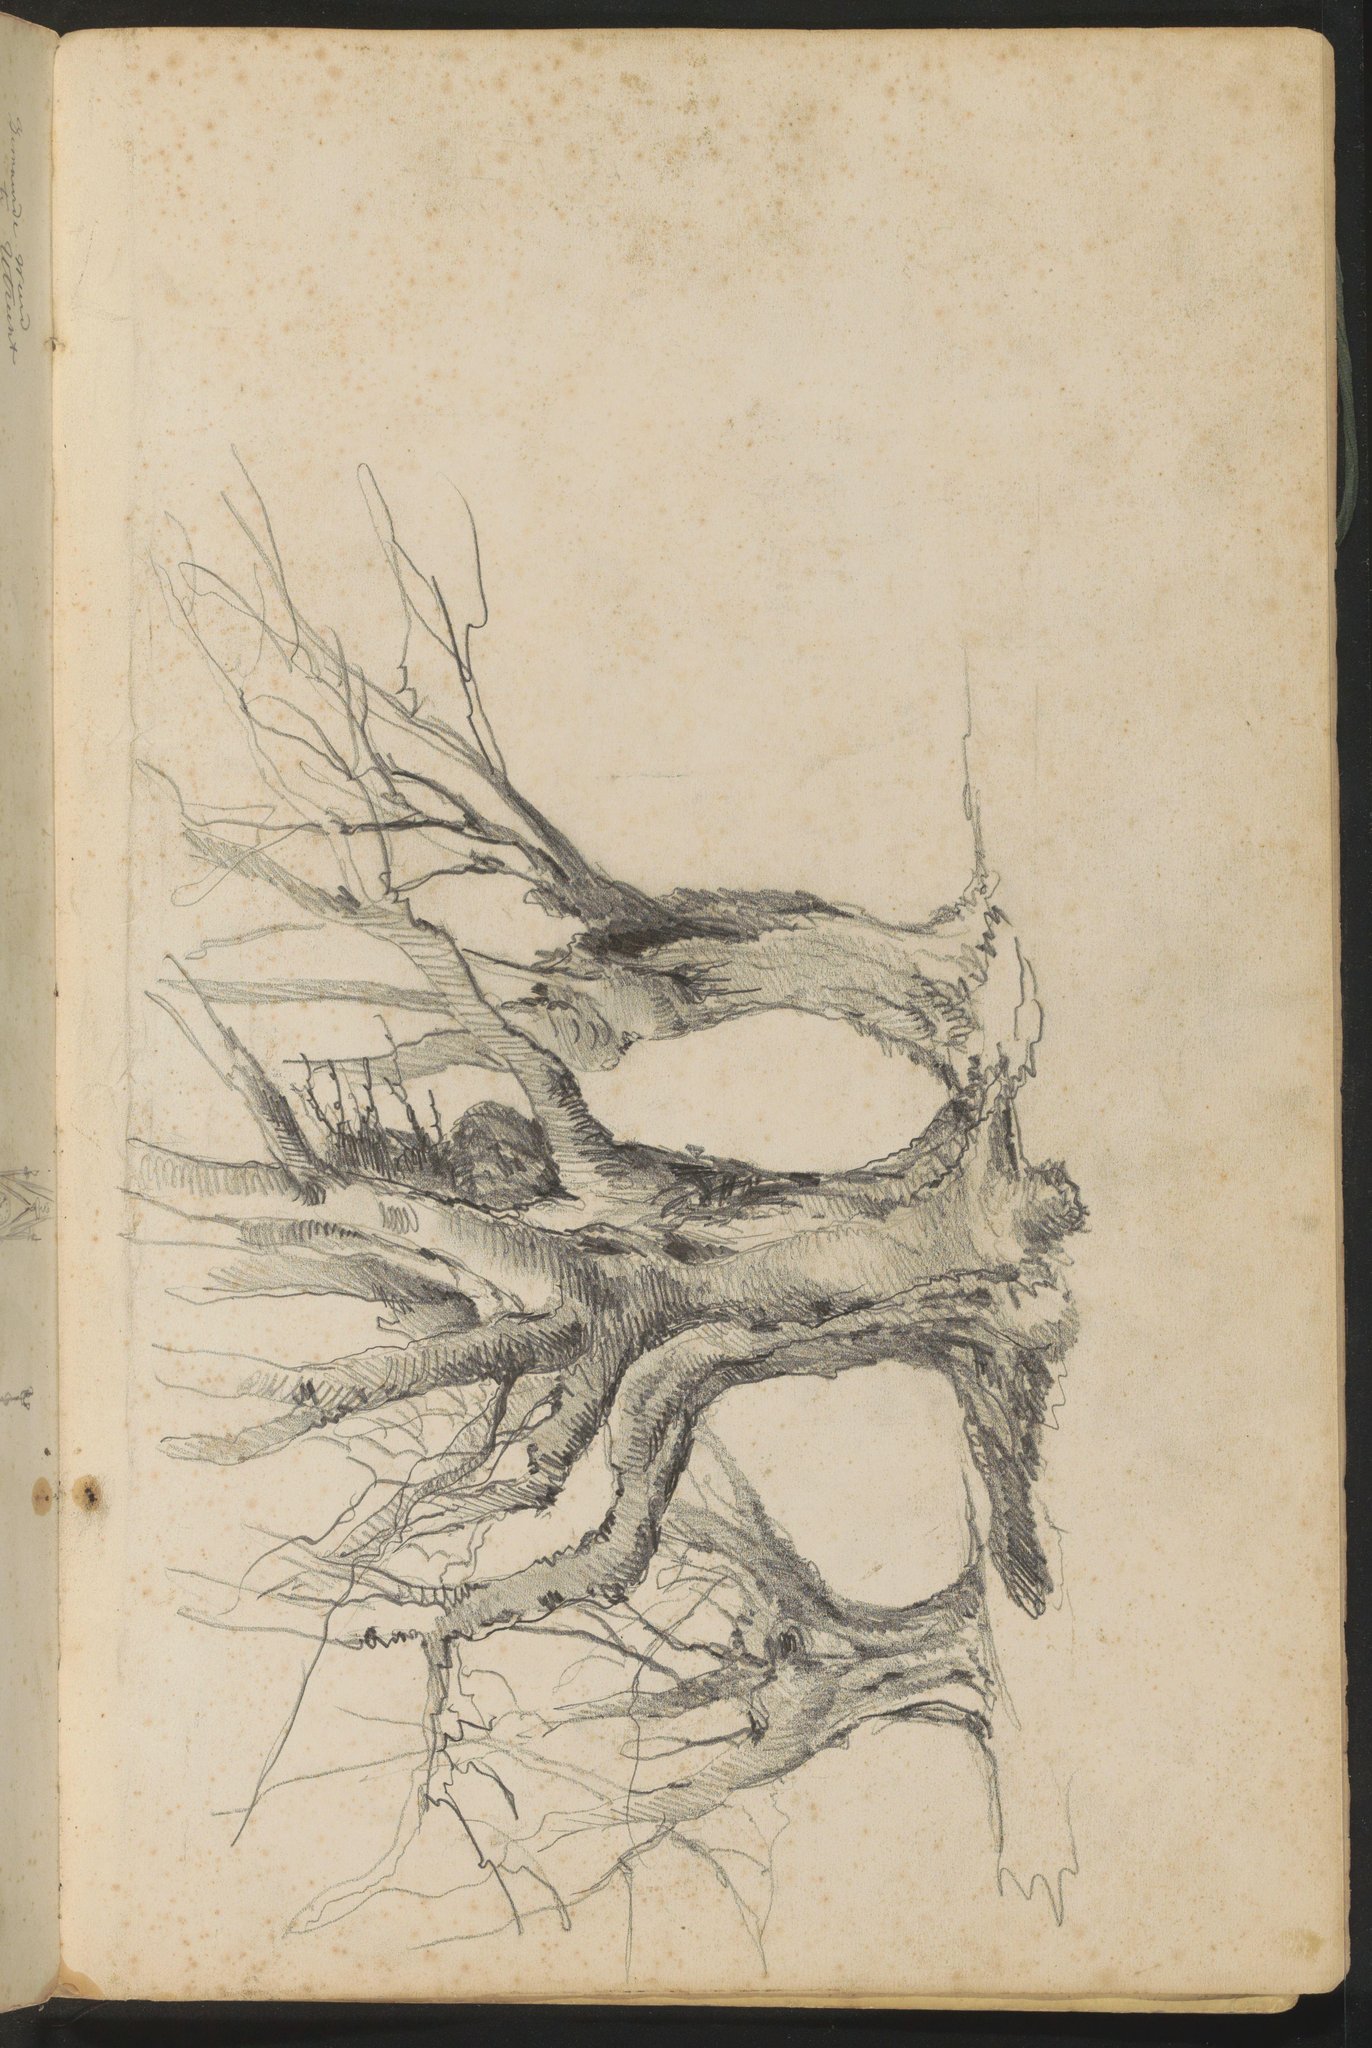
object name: sketchbook leaf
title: Drie knotwilgen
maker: willem koekkoek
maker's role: draughtsman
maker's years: 1839-1895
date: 1849-1895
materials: paper, pencil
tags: trees: willow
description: Blad 35 recto uit een schetsboek met 35 bladen.